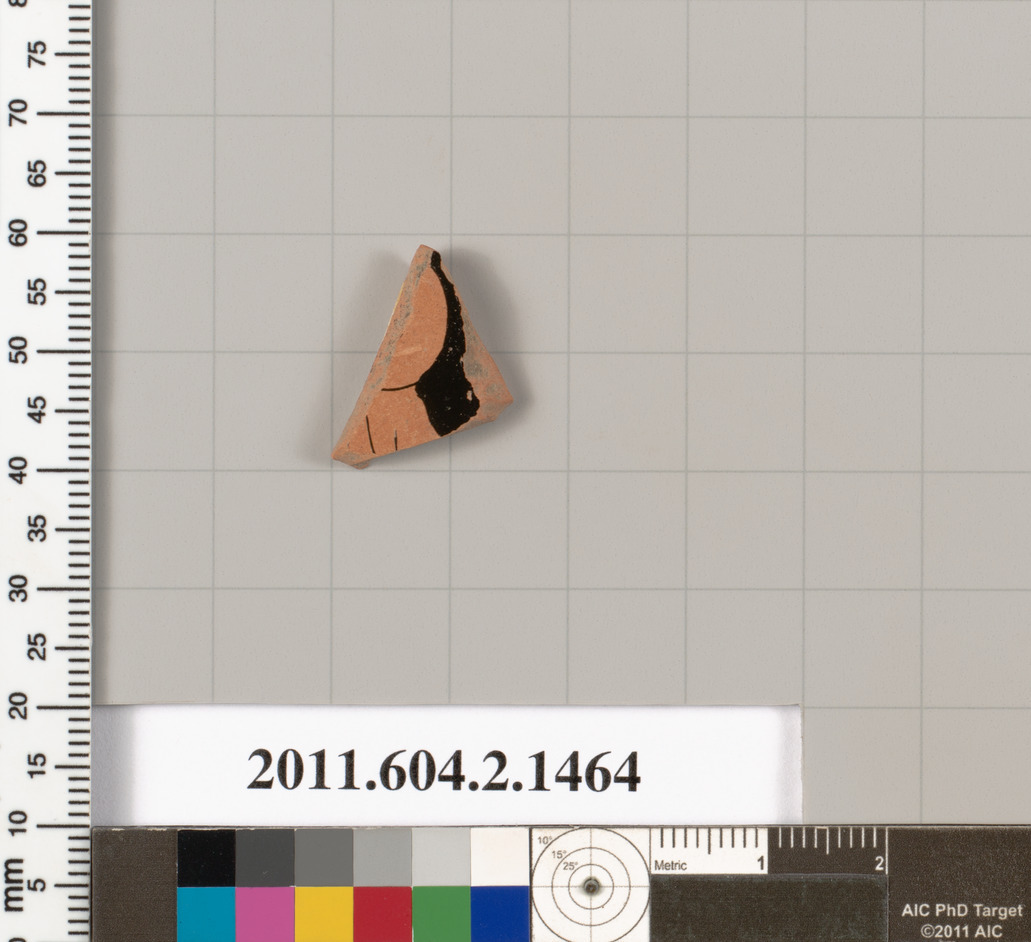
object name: skyphos fragment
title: Terracotta fragment of a skyphos (deep drinking cup)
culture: greek, attic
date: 450-426 BCE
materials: terracotta